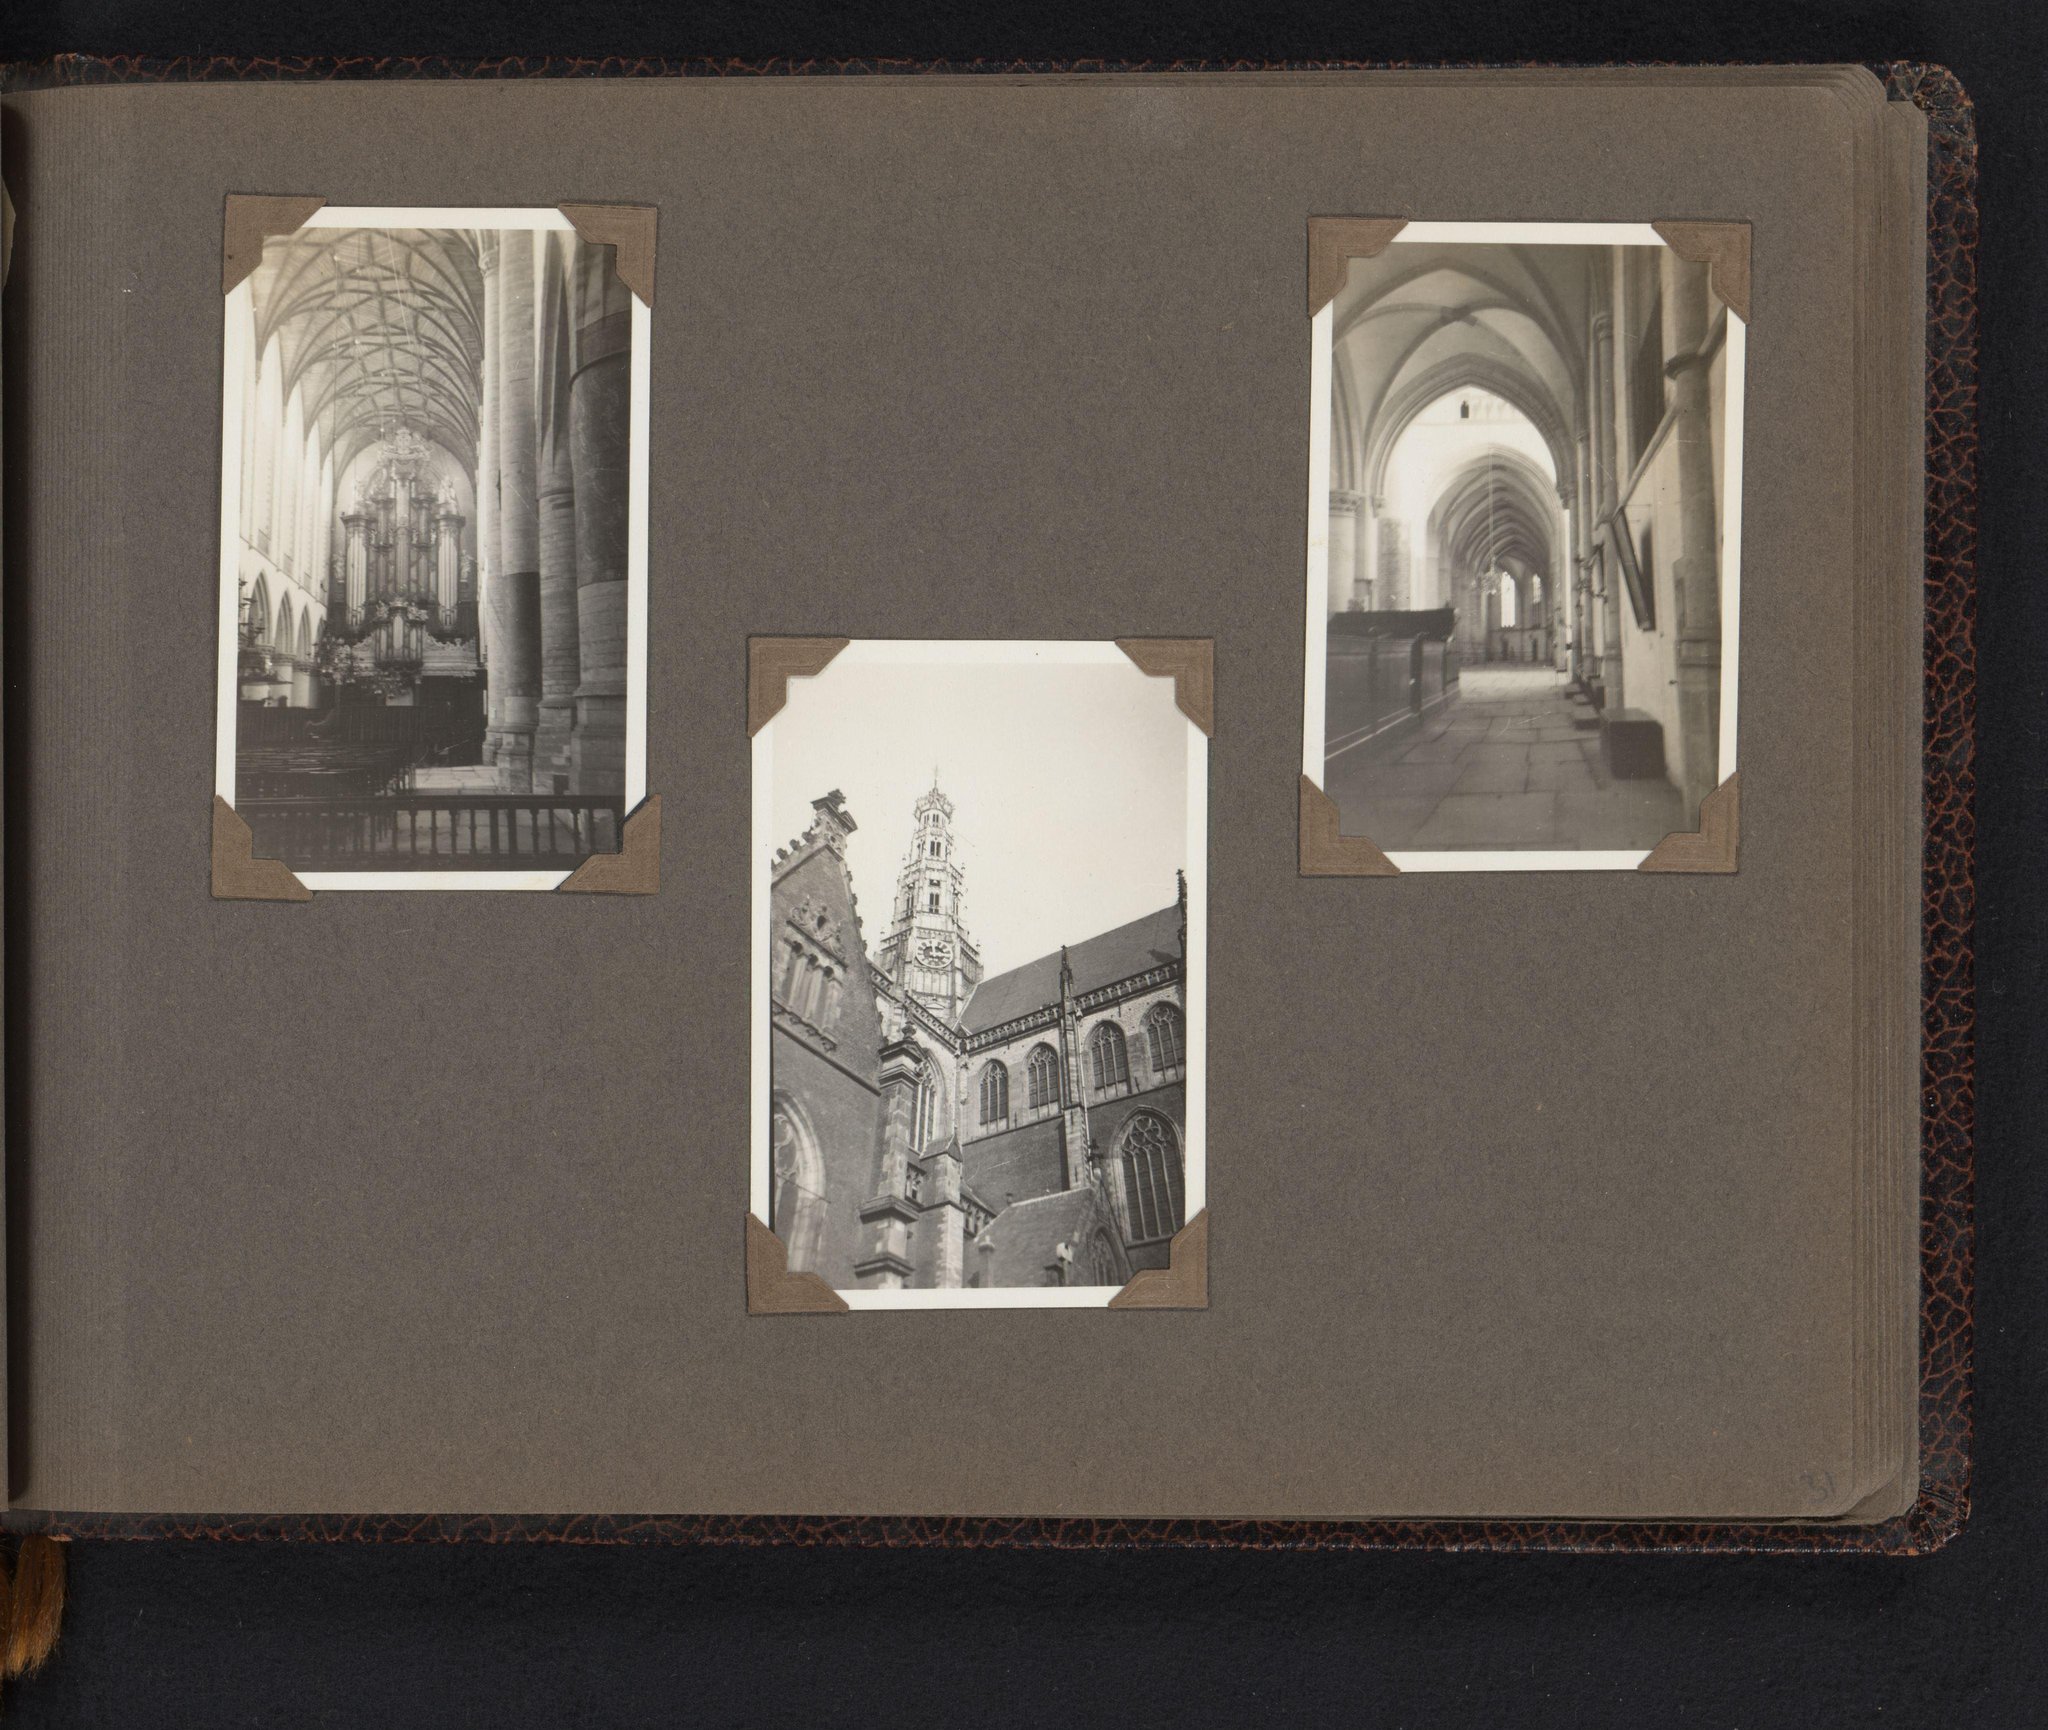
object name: photograph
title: Bezoek aan de Sint-Bavokerk te Haarlem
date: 1910-1930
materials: cardboard, paper, photographic support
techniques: gelatin silver print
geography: leiden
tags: church (exterior), interior of church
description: Drie foto's van de Sint-Bavokerk te Haarlem. Deze pagina maakt deel uit van een album.